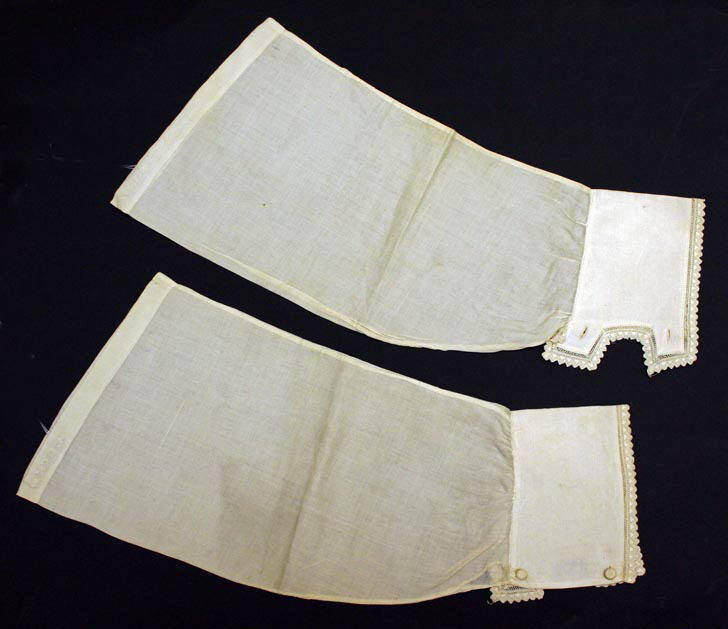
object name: undersleeves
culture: american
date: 1850-1879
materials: cotton